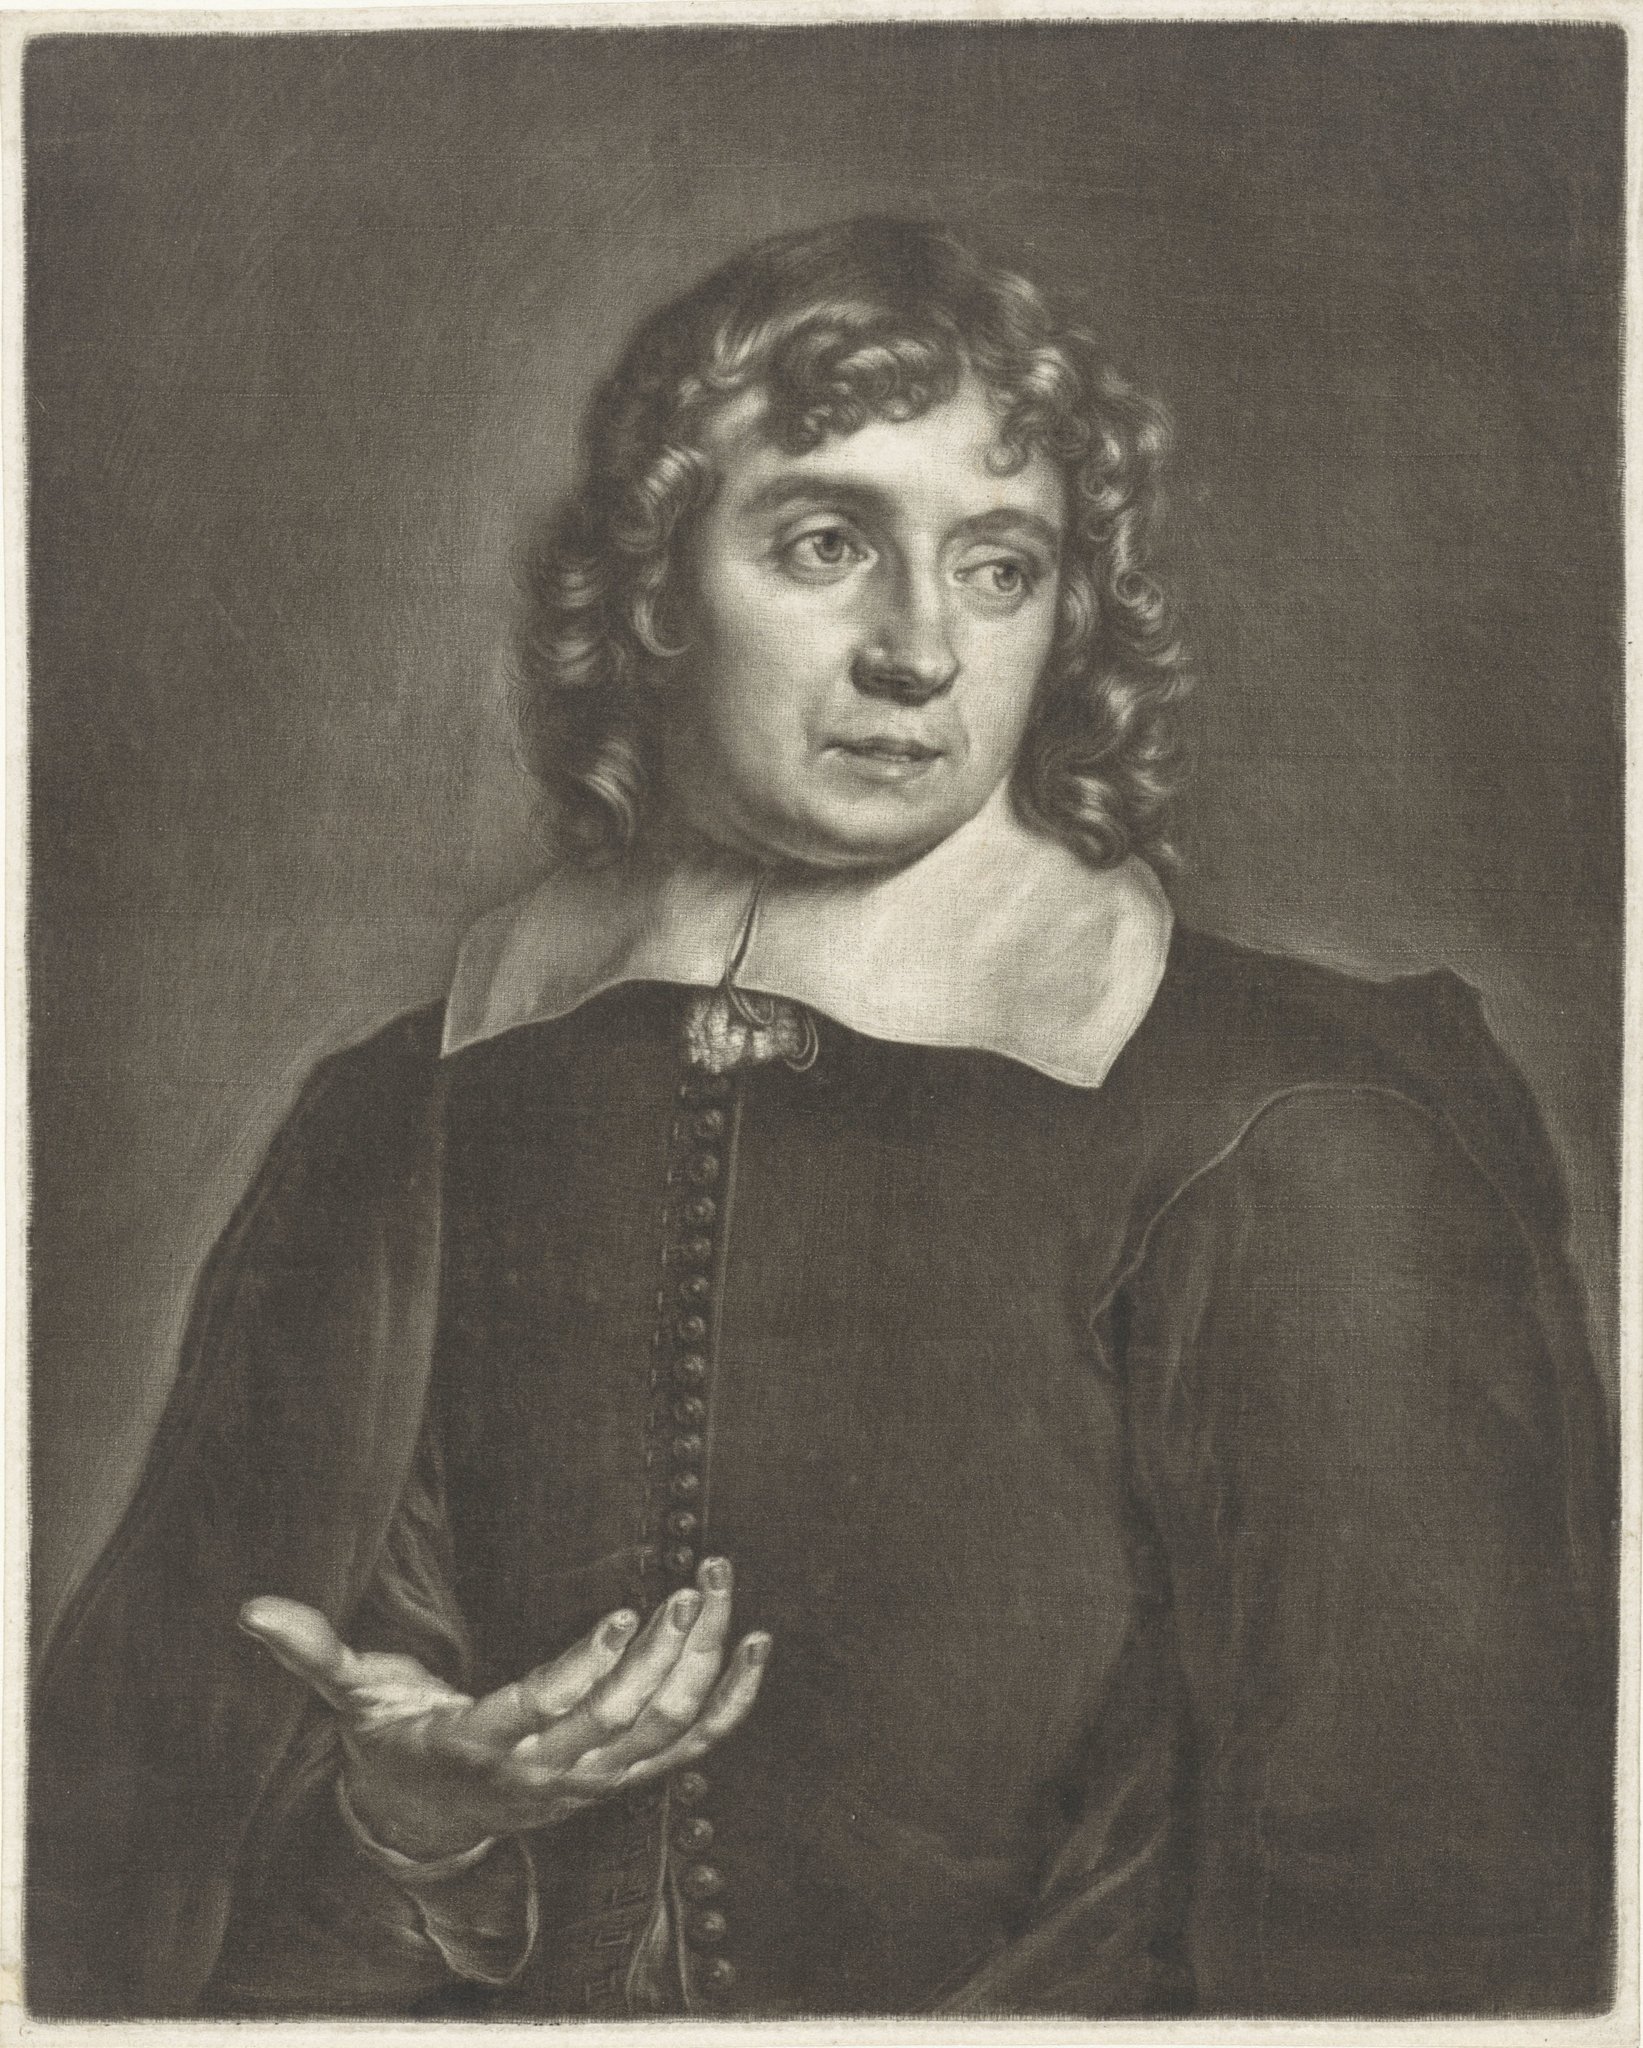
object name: print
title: Portret van J. Heermans of Pieter Harmans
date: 1642-1698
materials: paper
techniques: mezzotint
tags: petrus harmans, j. heermans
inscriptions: collector's mark: Lugt 2228